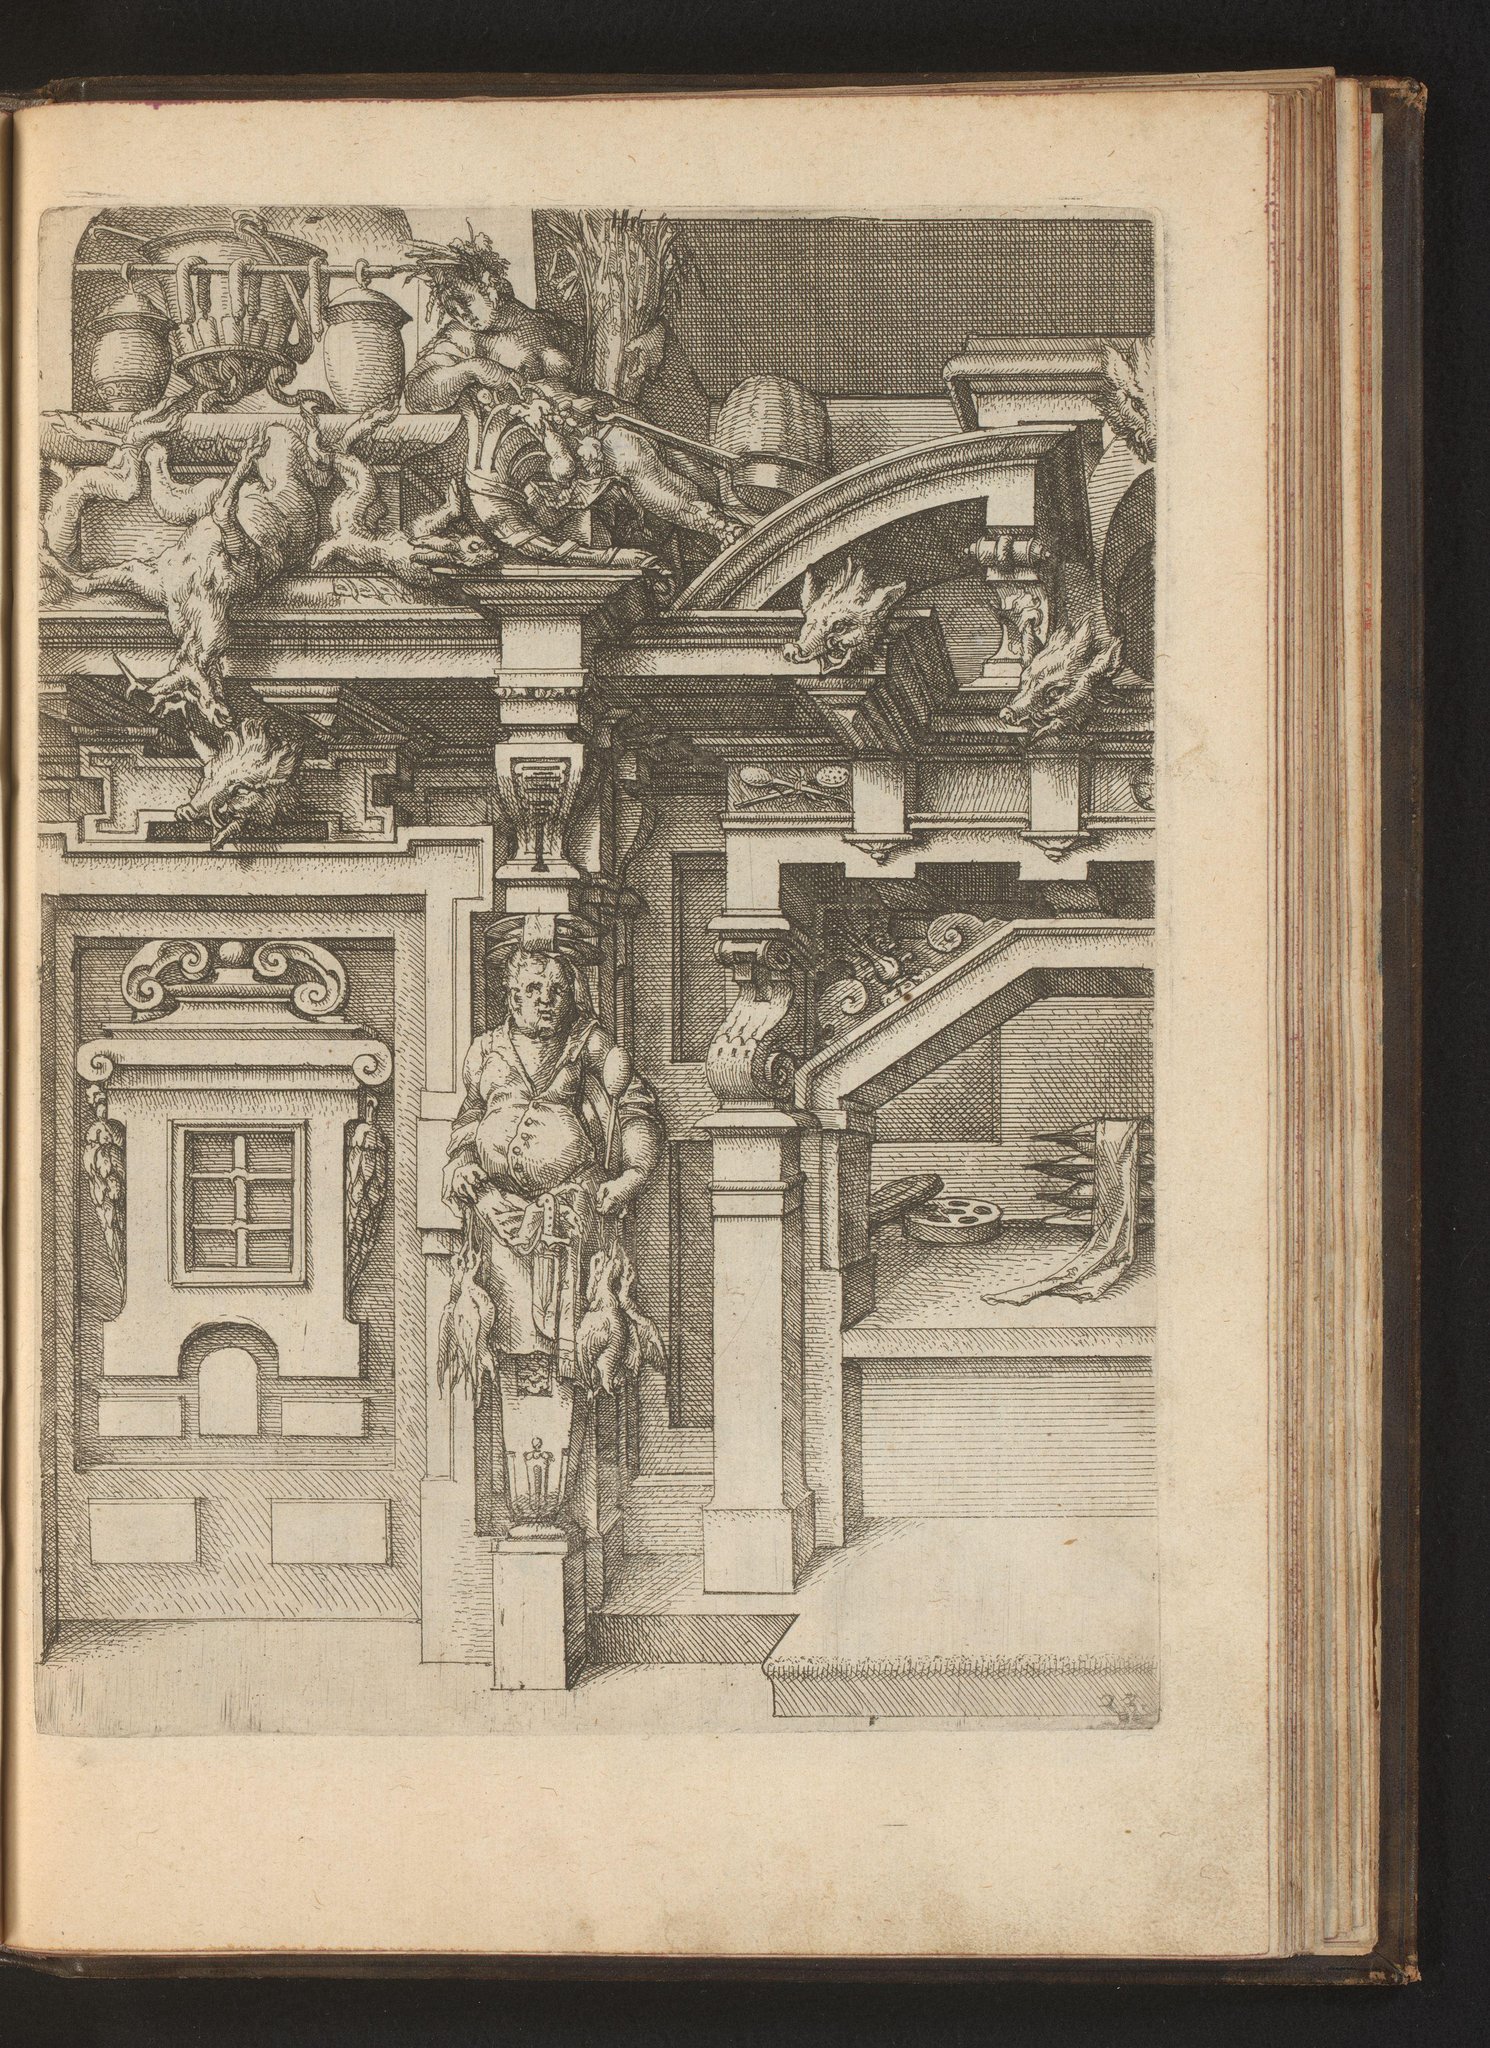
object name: ornament print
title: Architectura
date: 1593-1595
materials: paper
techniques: etching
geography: straatsburg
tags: parts of church exterior and annexes: portal, specific aspects, allegorical aspects of ceres; ceres as patroness, oven ~ kitchen, ornament derived from architectural details, meat; still life of meat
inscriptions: collector's mark: Lugt 2760, collector's mark: Lugt 2228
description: Prent gebruikt in: Dietterlin, Wendel (I). Wendel Dietterlin, Architectura de Polstium seu Portalium ornatu uario Liber II. Straatsburg: Bernhard Jobin, 1594.